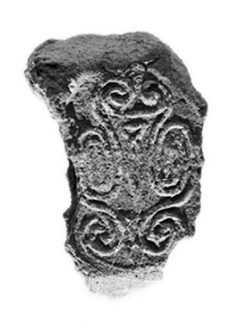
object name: sealing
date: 1981-1640 BCE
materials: mud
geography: egypt